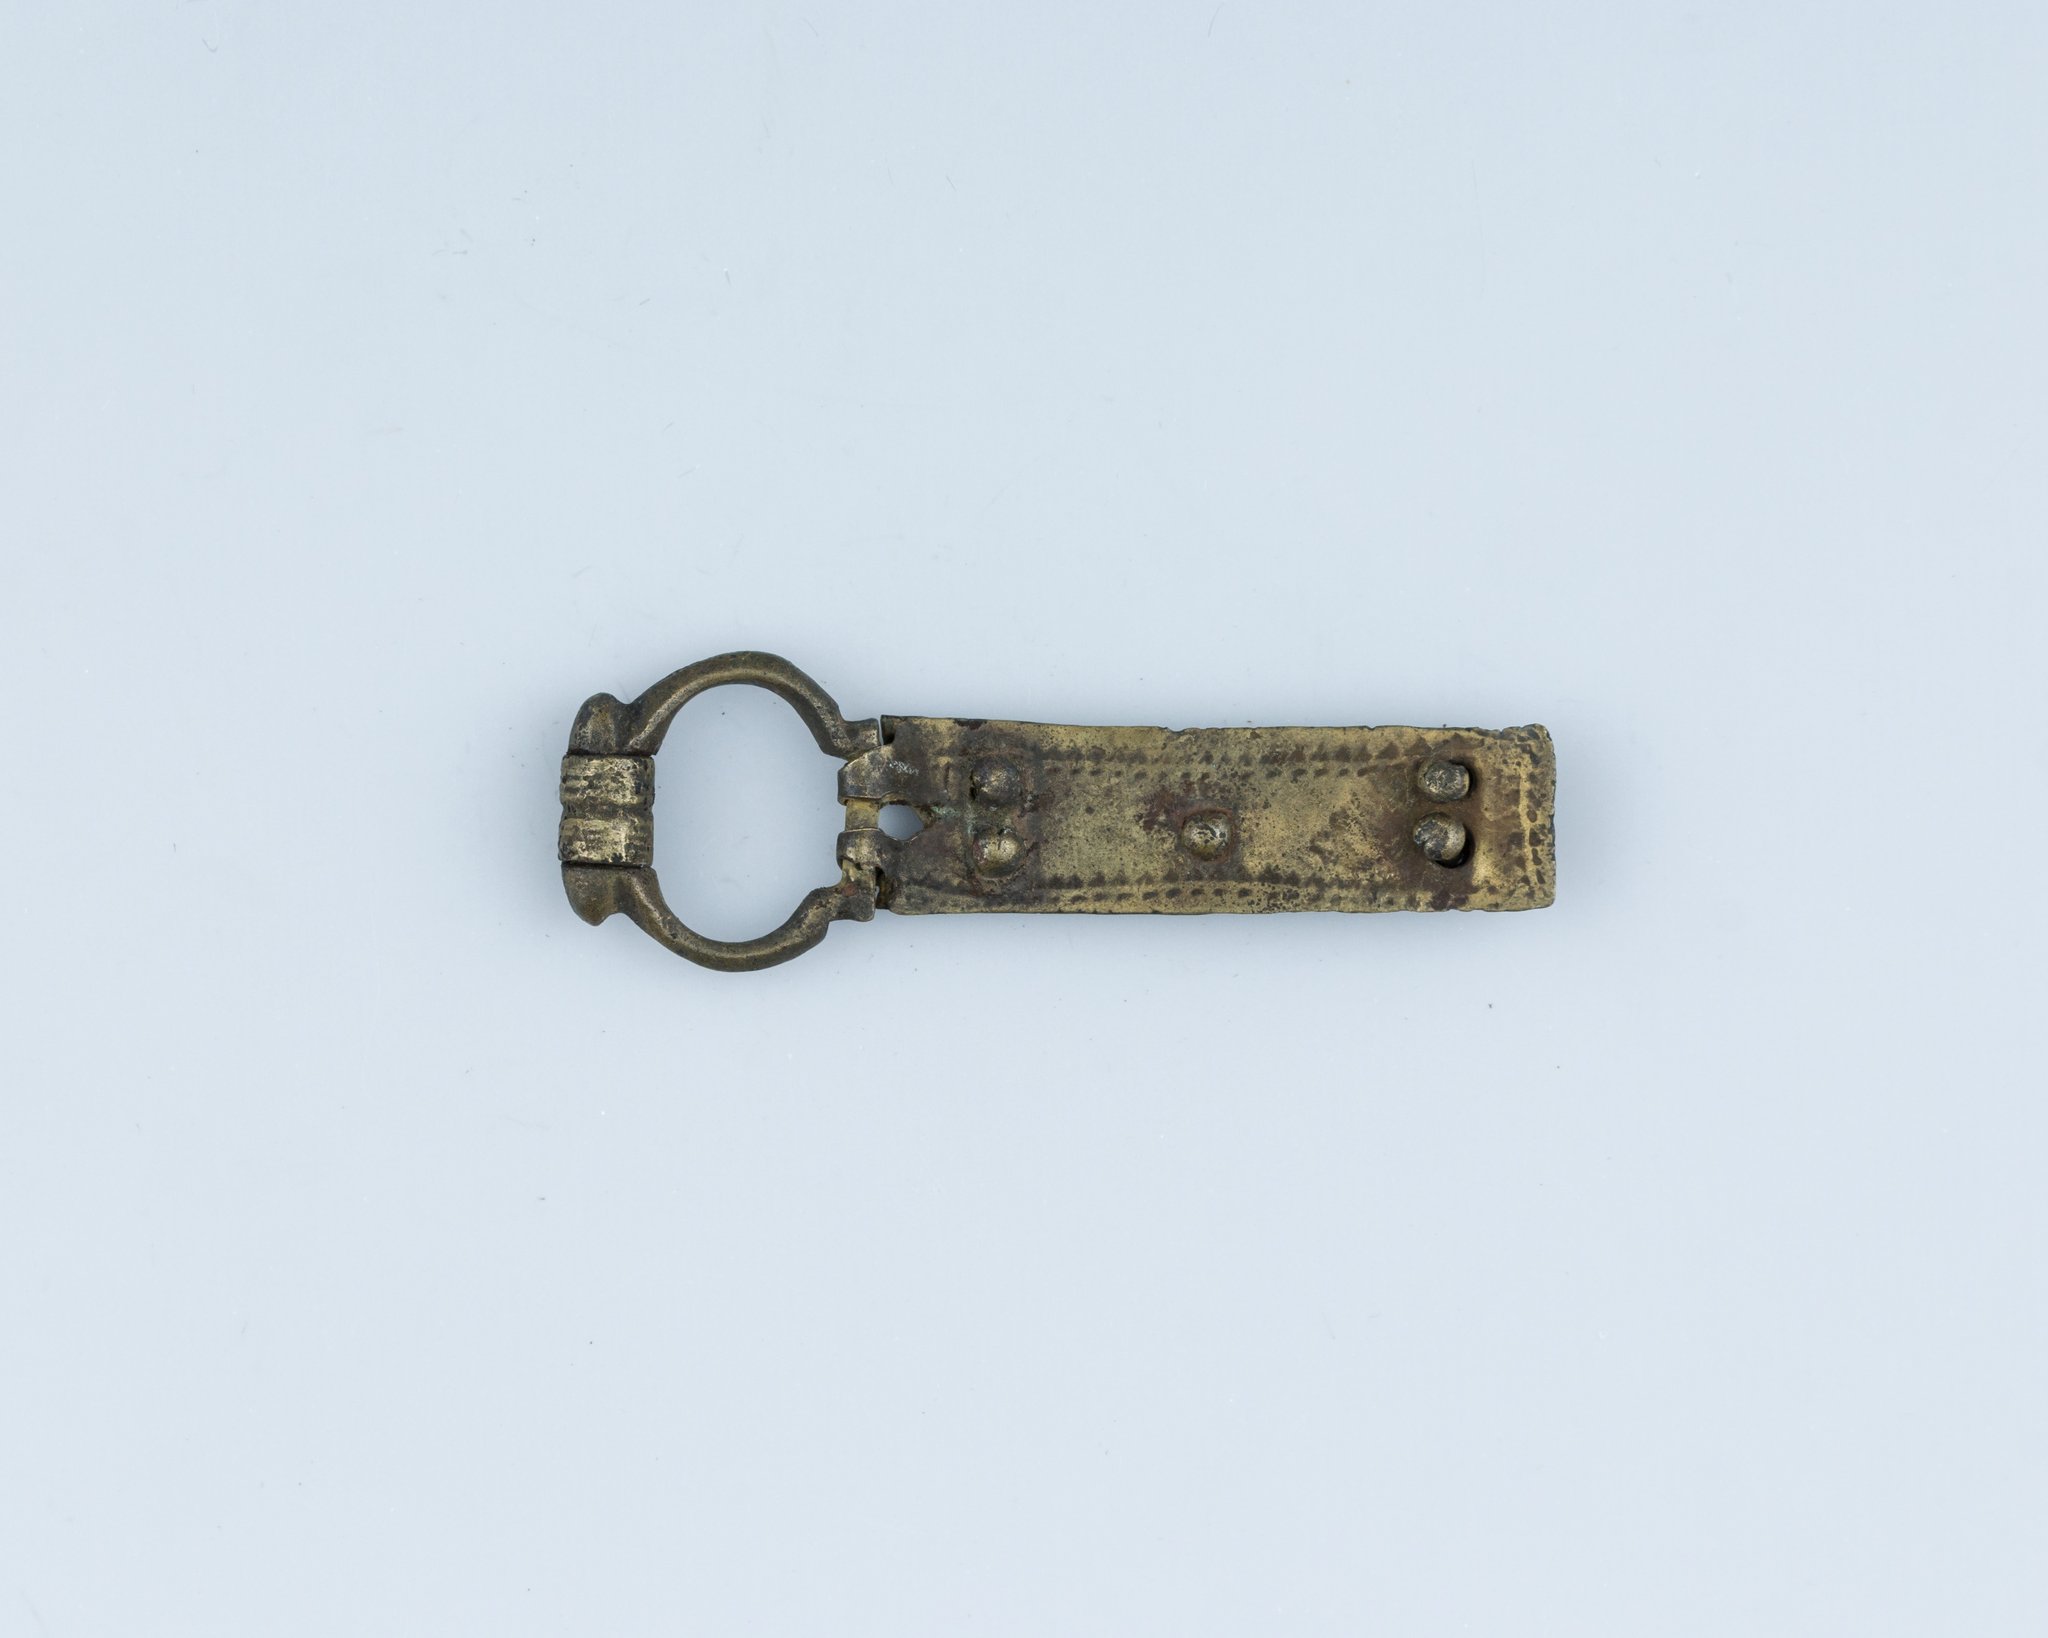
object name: buckle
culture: french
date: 1400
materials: brass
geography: france